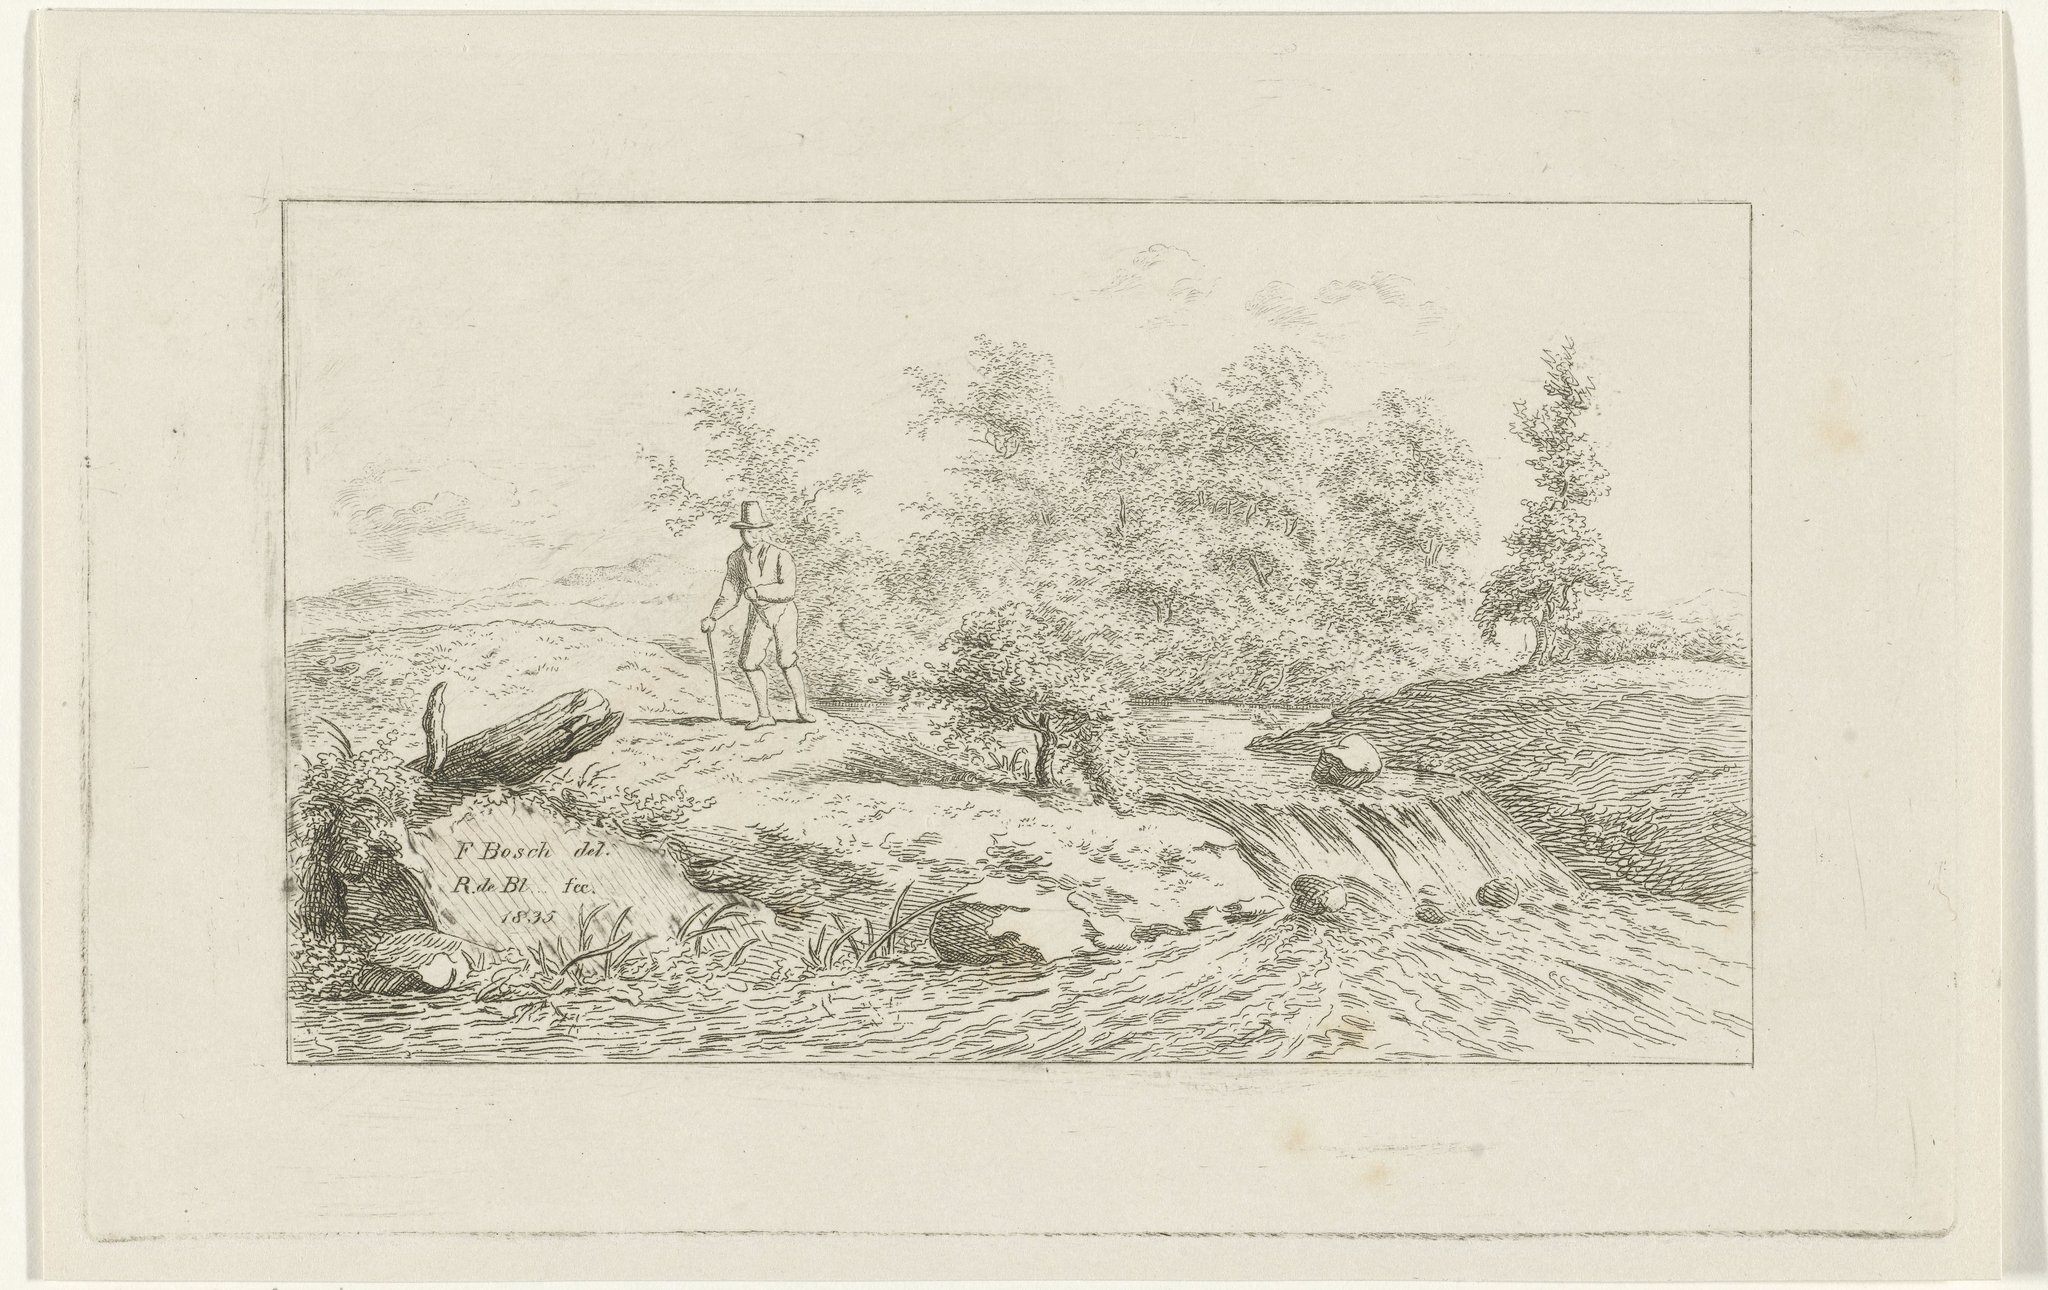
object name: print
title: Man bij een waterval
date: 1835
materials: paper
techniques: etching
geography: vaassen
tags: walking-stick, staff, waterfall, landscapes (+ landscape with figures, staffage)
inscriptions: collector's mark: Lugt 2228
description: Man met een wandelstok bij een waterval.